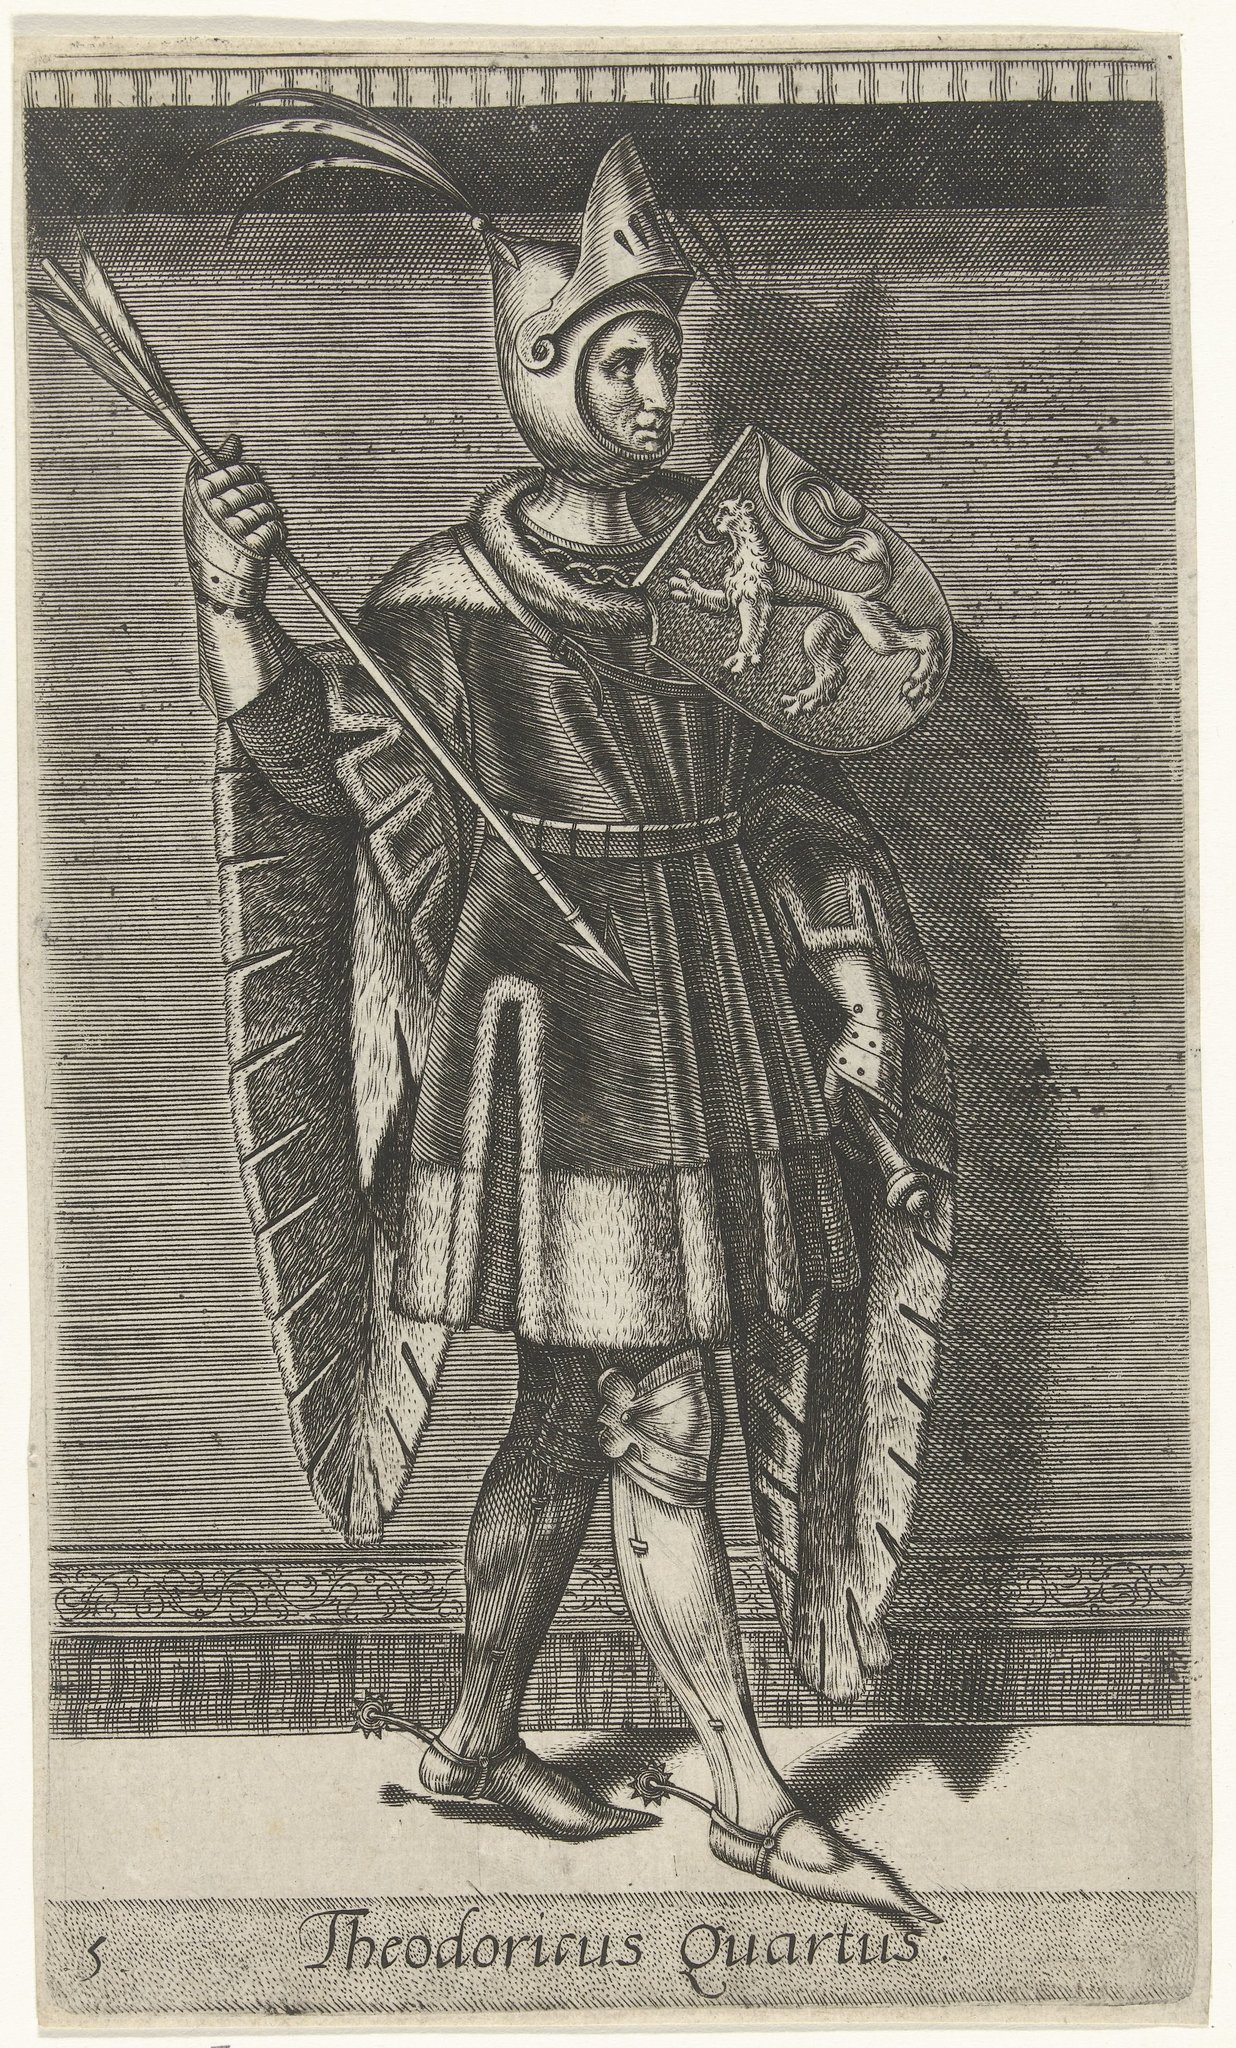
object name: book illustration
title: Principes Hollandiae et Zelandiae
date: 1578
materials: paper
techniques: engraving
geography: antwerp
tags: dirk iv (graaf van holland)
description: Dirk IV, graaf van Holland, staande, ten voeten uit. Hij heeft een speer in de hand. Op zijn linkerschouder het wapenschild van Holland. De prent dient als een illustratie bij een boek over de geschiedenis van de graven van Holland.